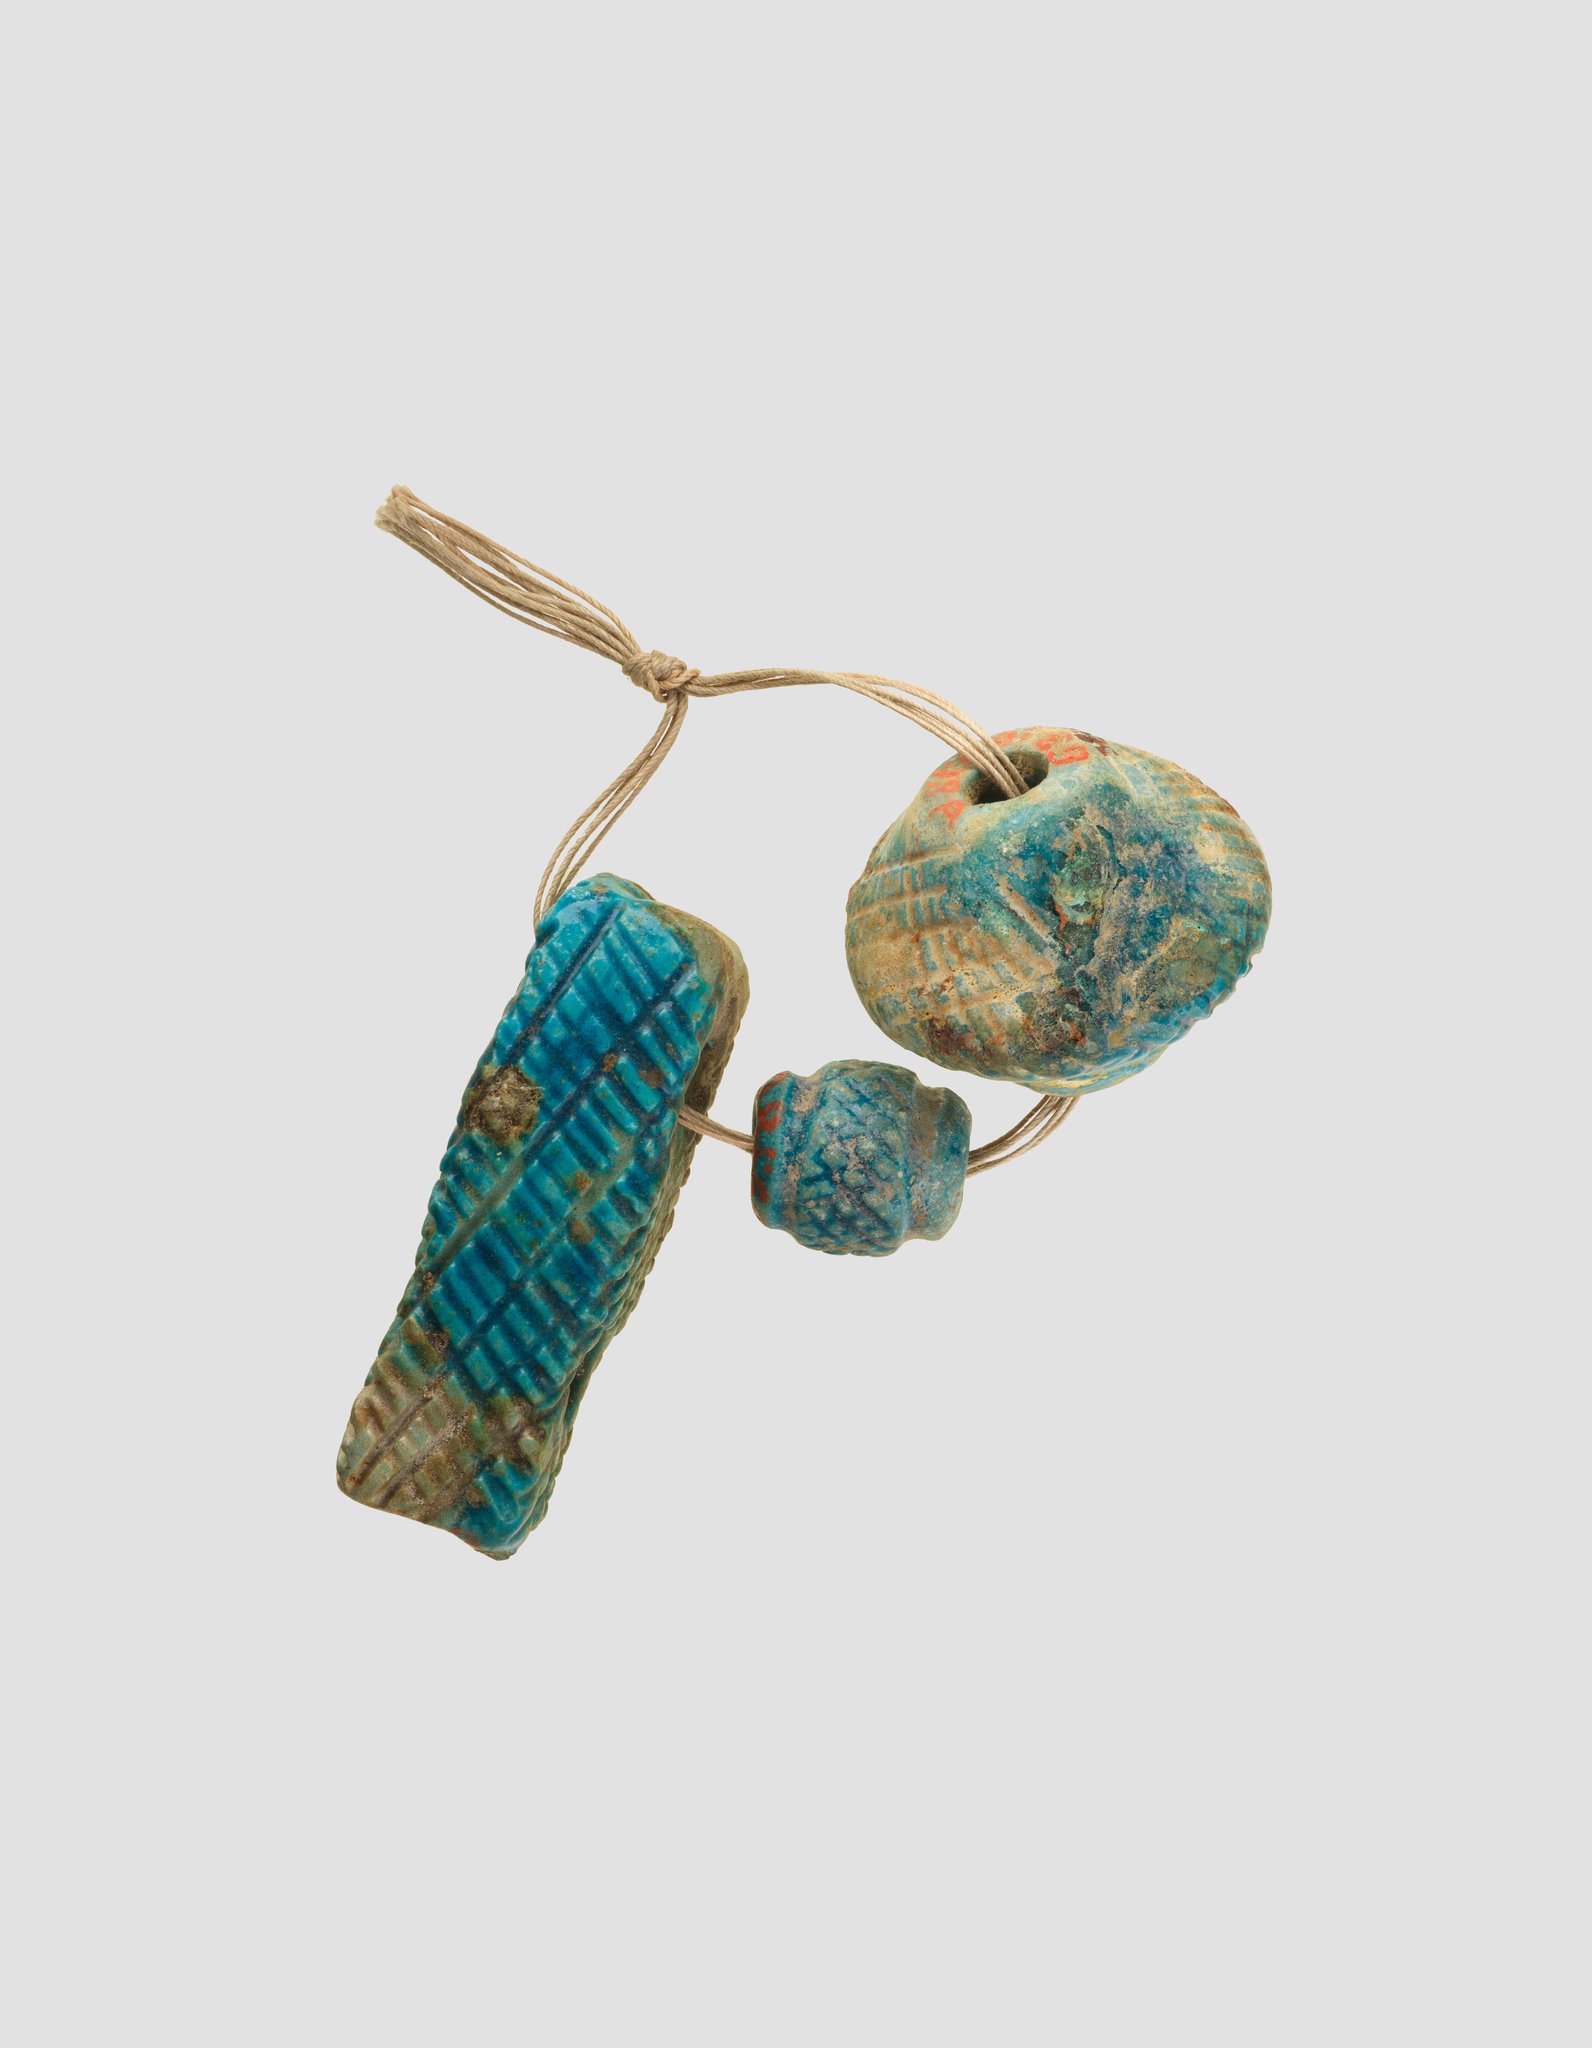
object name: bead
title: Beads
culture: iranian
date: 900-801 BCE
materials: faience, glaze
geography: iran